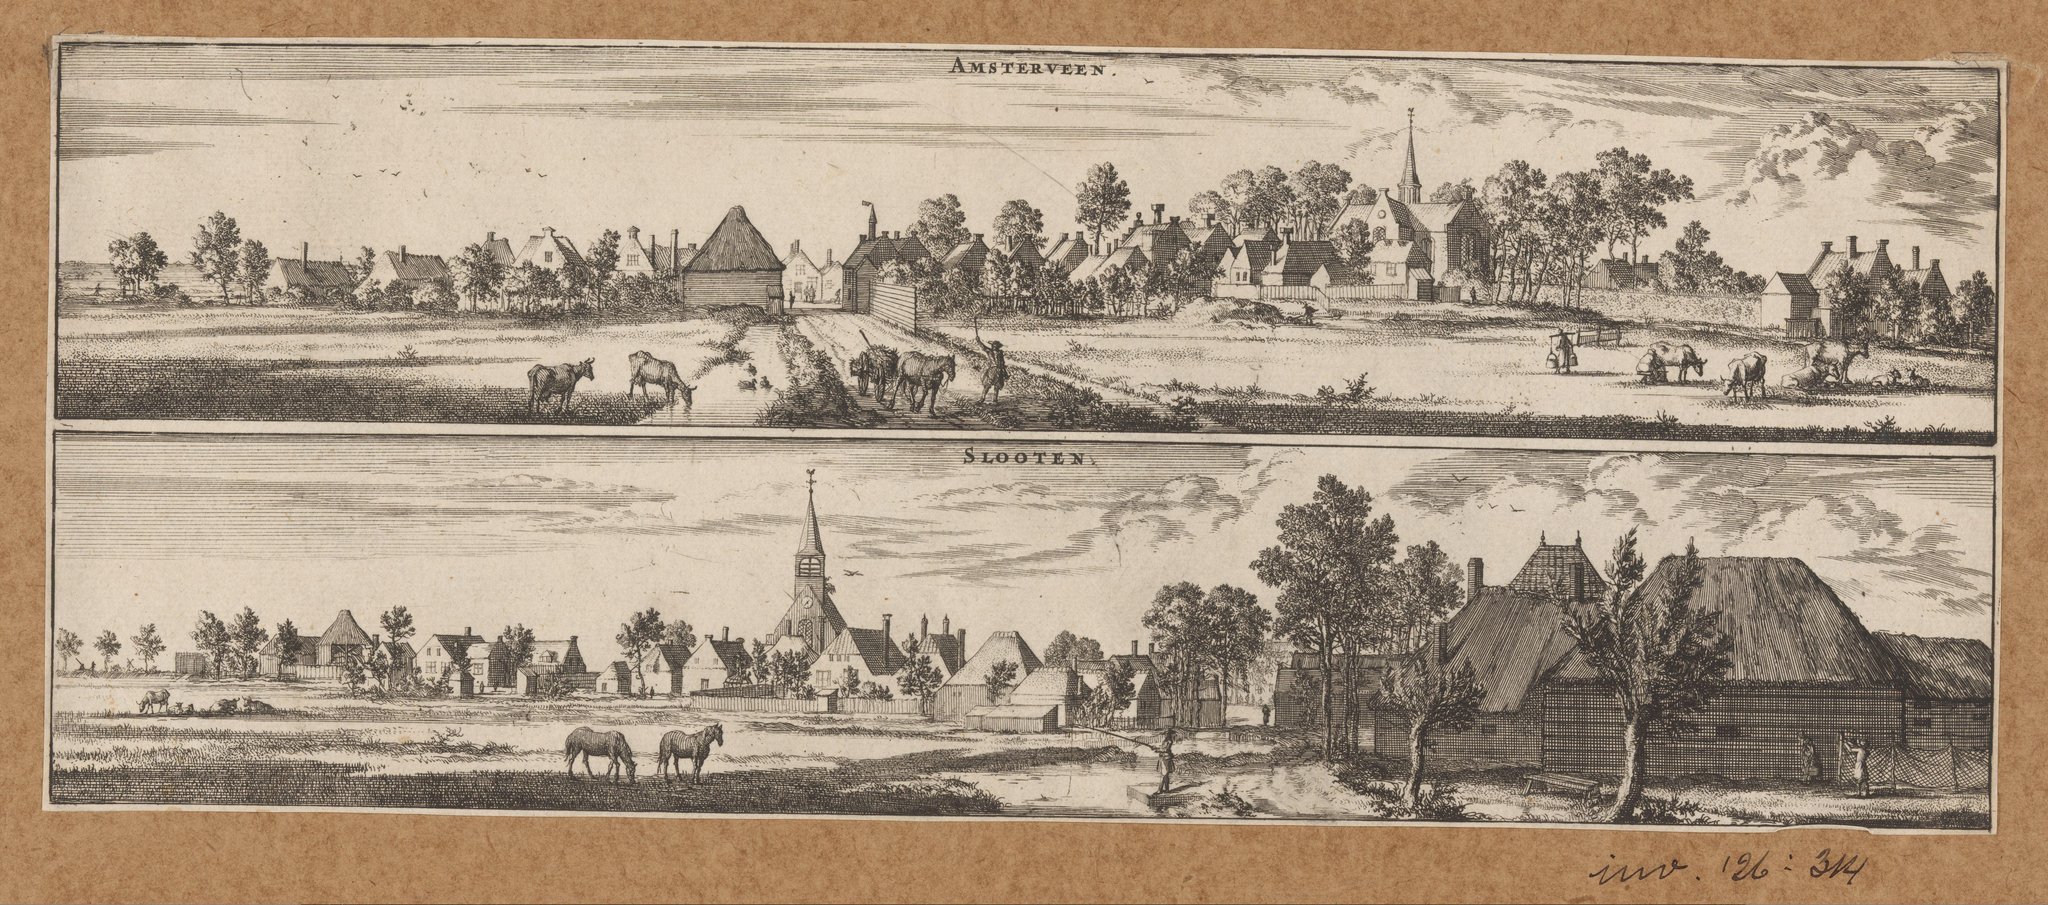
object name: print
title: Gezichten op Amstelveen en Sloten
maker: jan luyken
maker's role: draughtsman, print maker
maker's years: 1649-1712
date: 1693-1726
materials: paper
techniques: etching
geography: amsterdam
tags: prospect of village, silhouette of village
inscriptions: collector's mark: Lugt 2233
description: Prent behoort tot een geheel met vier stadsgezichten van de steden Amstelveen, Sloten, Sloterdijk en Osdorp.